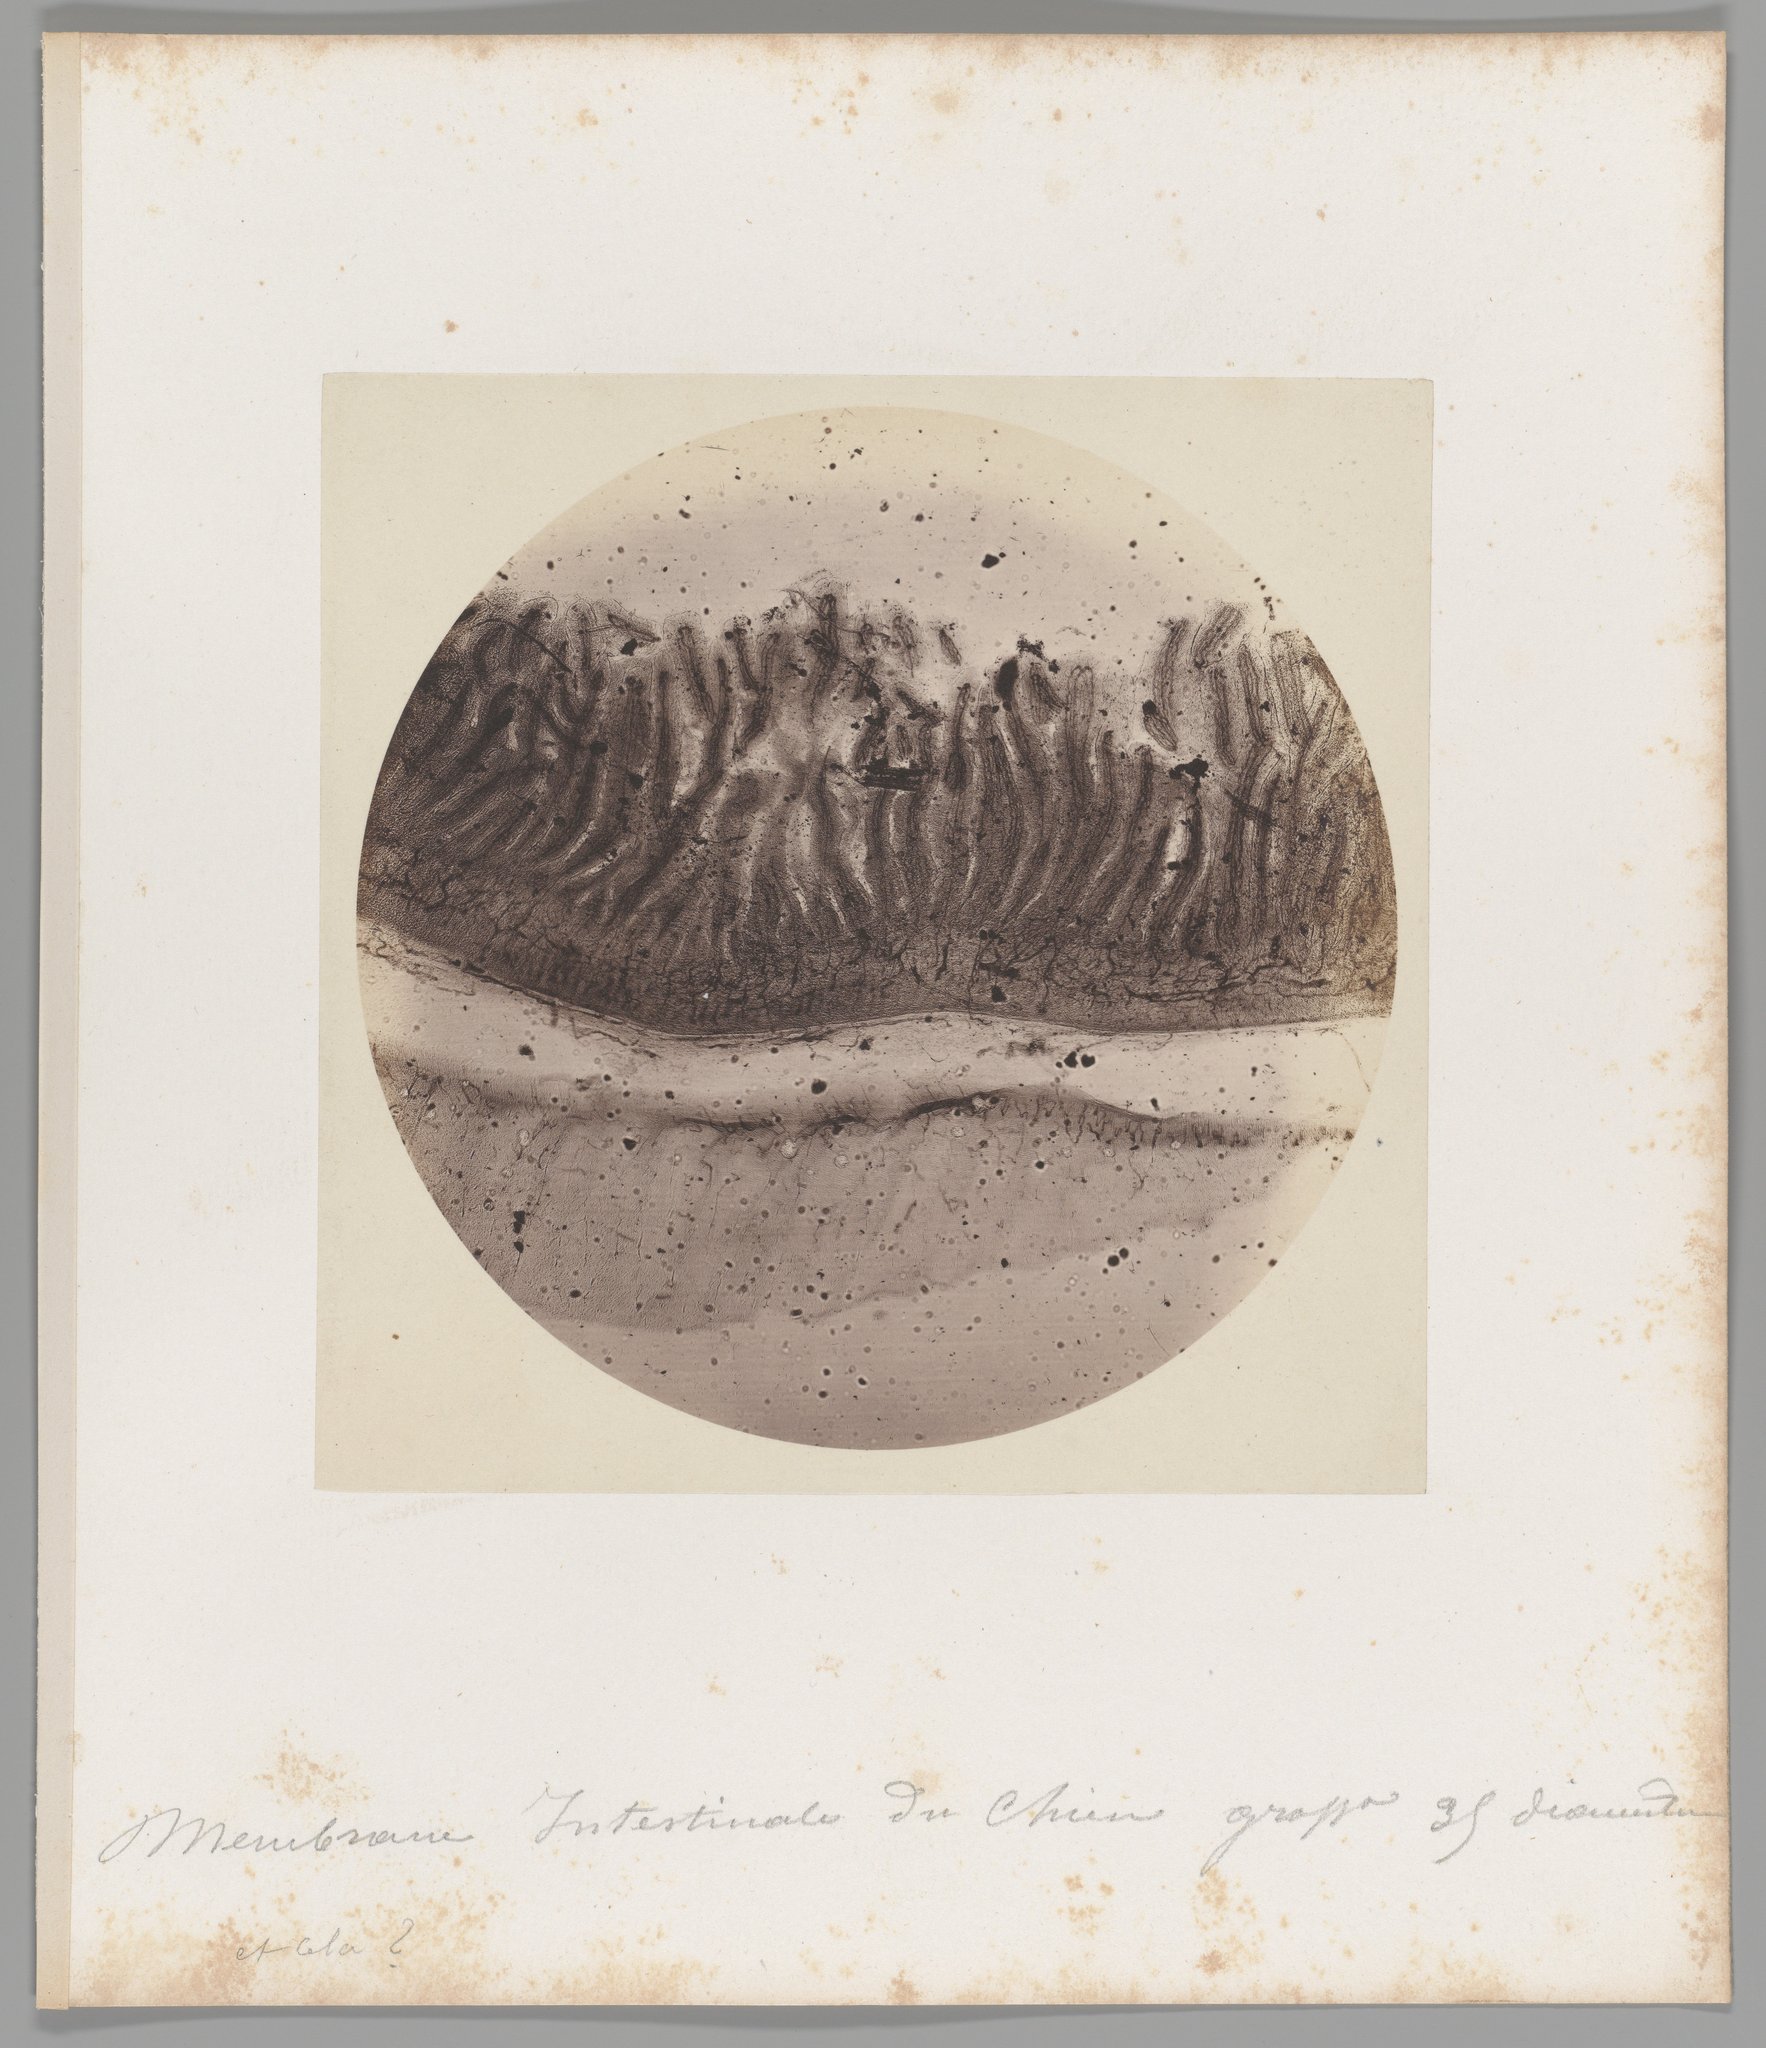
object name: photograph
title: Membrane Intestinale du chien grosse [Membrane of a Dog’s Intestine]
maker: auguste-adolphe bertsch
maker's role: artist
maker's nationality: french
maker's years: 1813-1871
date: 1853-1857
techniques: salted paper print